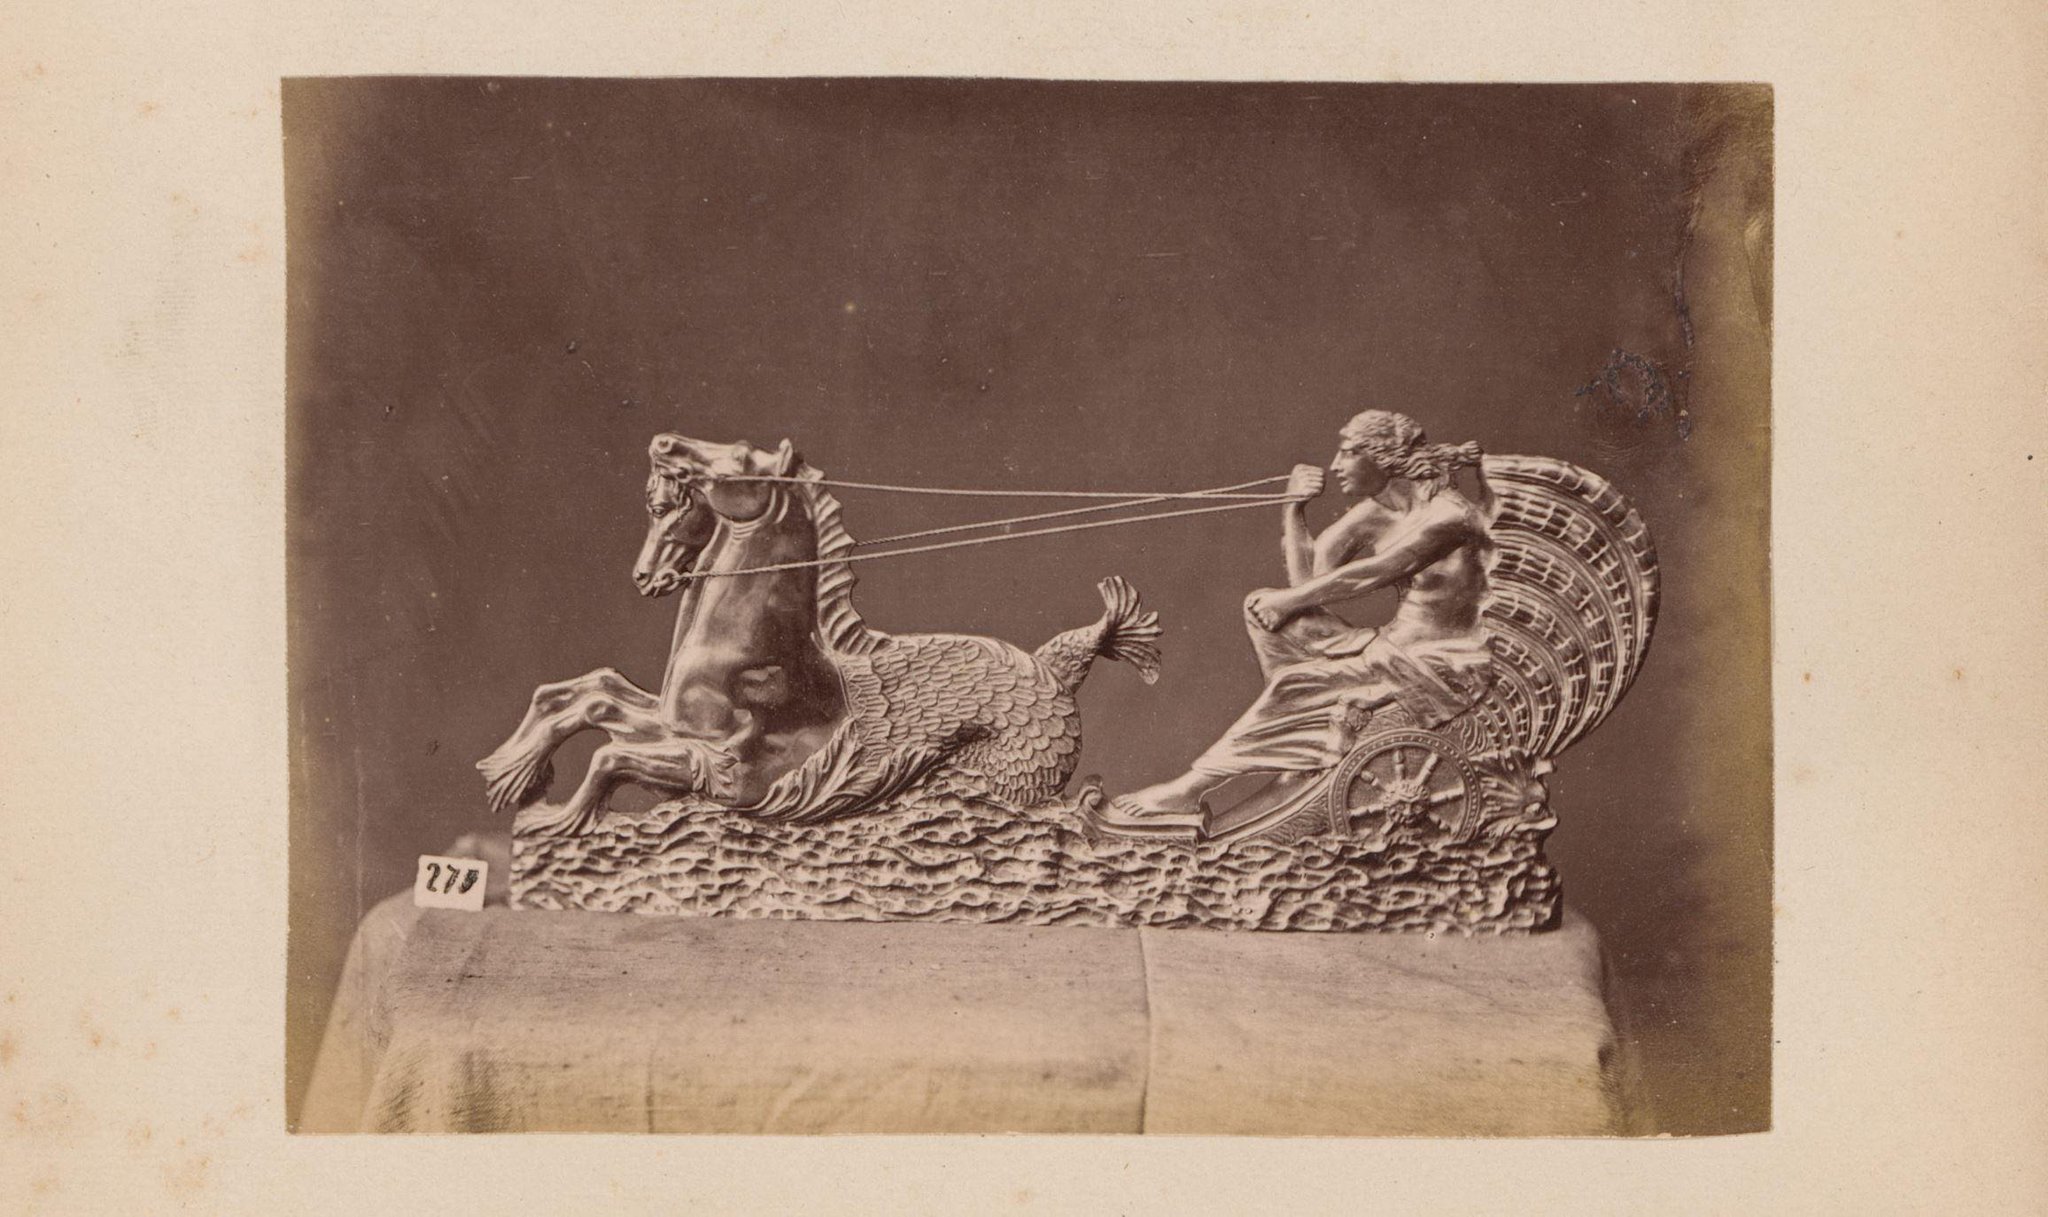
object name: page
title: Metalen reliëf van Neptunus op zijn wagen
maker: Anonymous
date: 1860-1885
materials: photographic support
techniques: albumen print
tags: (story of) neptune (poseidon)